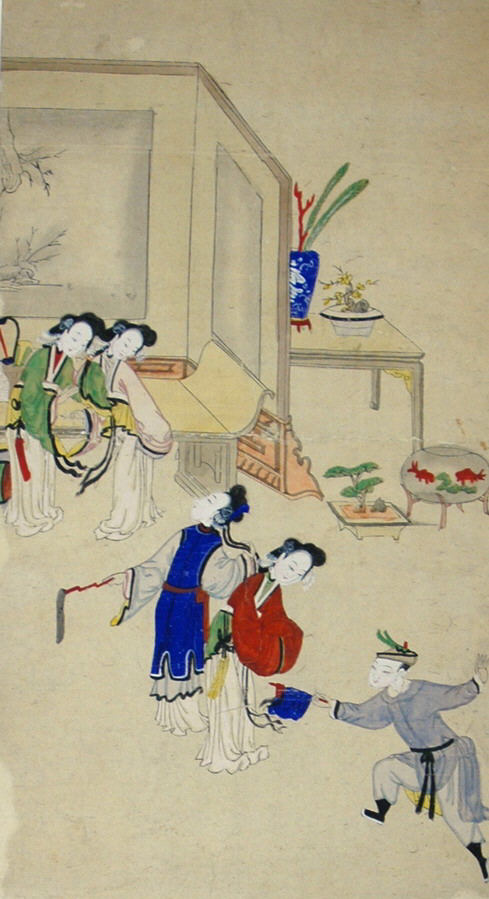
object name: print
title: Reporting a Happy Event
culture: chinese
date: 1801-1900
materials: ink, paper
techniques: polychrome, woodblock print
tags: men,women,fish